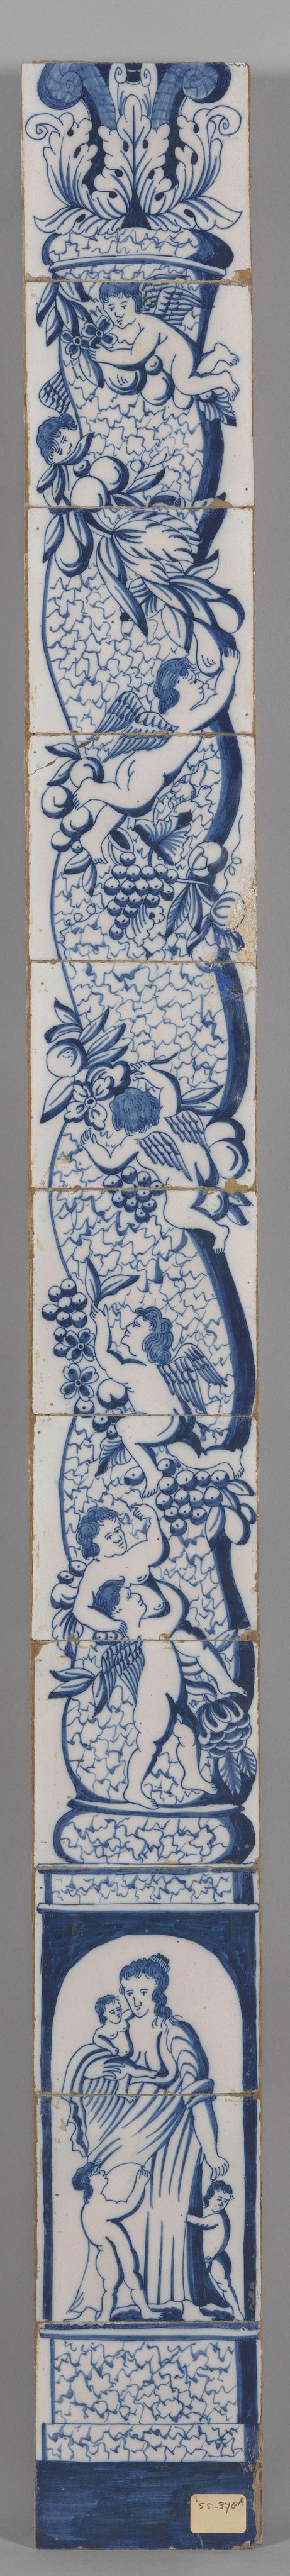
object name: tile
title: Tegeltableau liefde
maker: Anonymous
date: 1730-1770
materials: earthenware, glaze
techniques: maiolica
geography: friesland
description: Tegeltableau van elf tegels (11 x 1) met een blauw geschilderde getorste zuil versierd met putti en bloemen- en vruchtenranken. De zuil staat op een vierkant voetstuk met een staande vrouw omgeven door drie kinderen, zinnebeeld van de liefde.